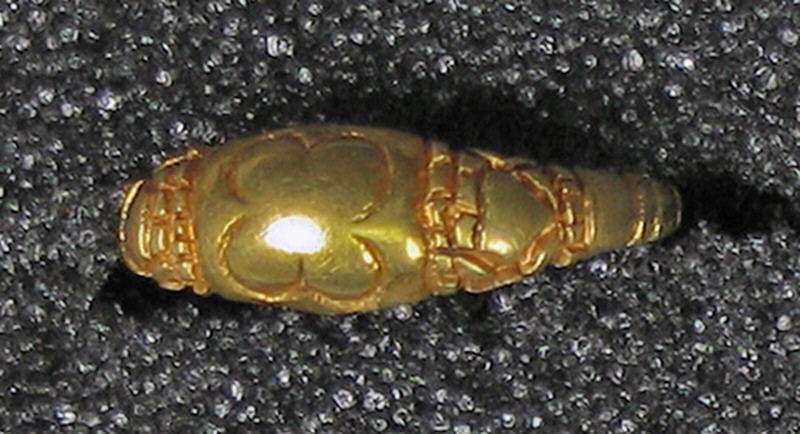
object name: ring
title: Hollow Ring, Foliate and Oval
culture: indonesian, east java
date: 1101-1400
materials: gold